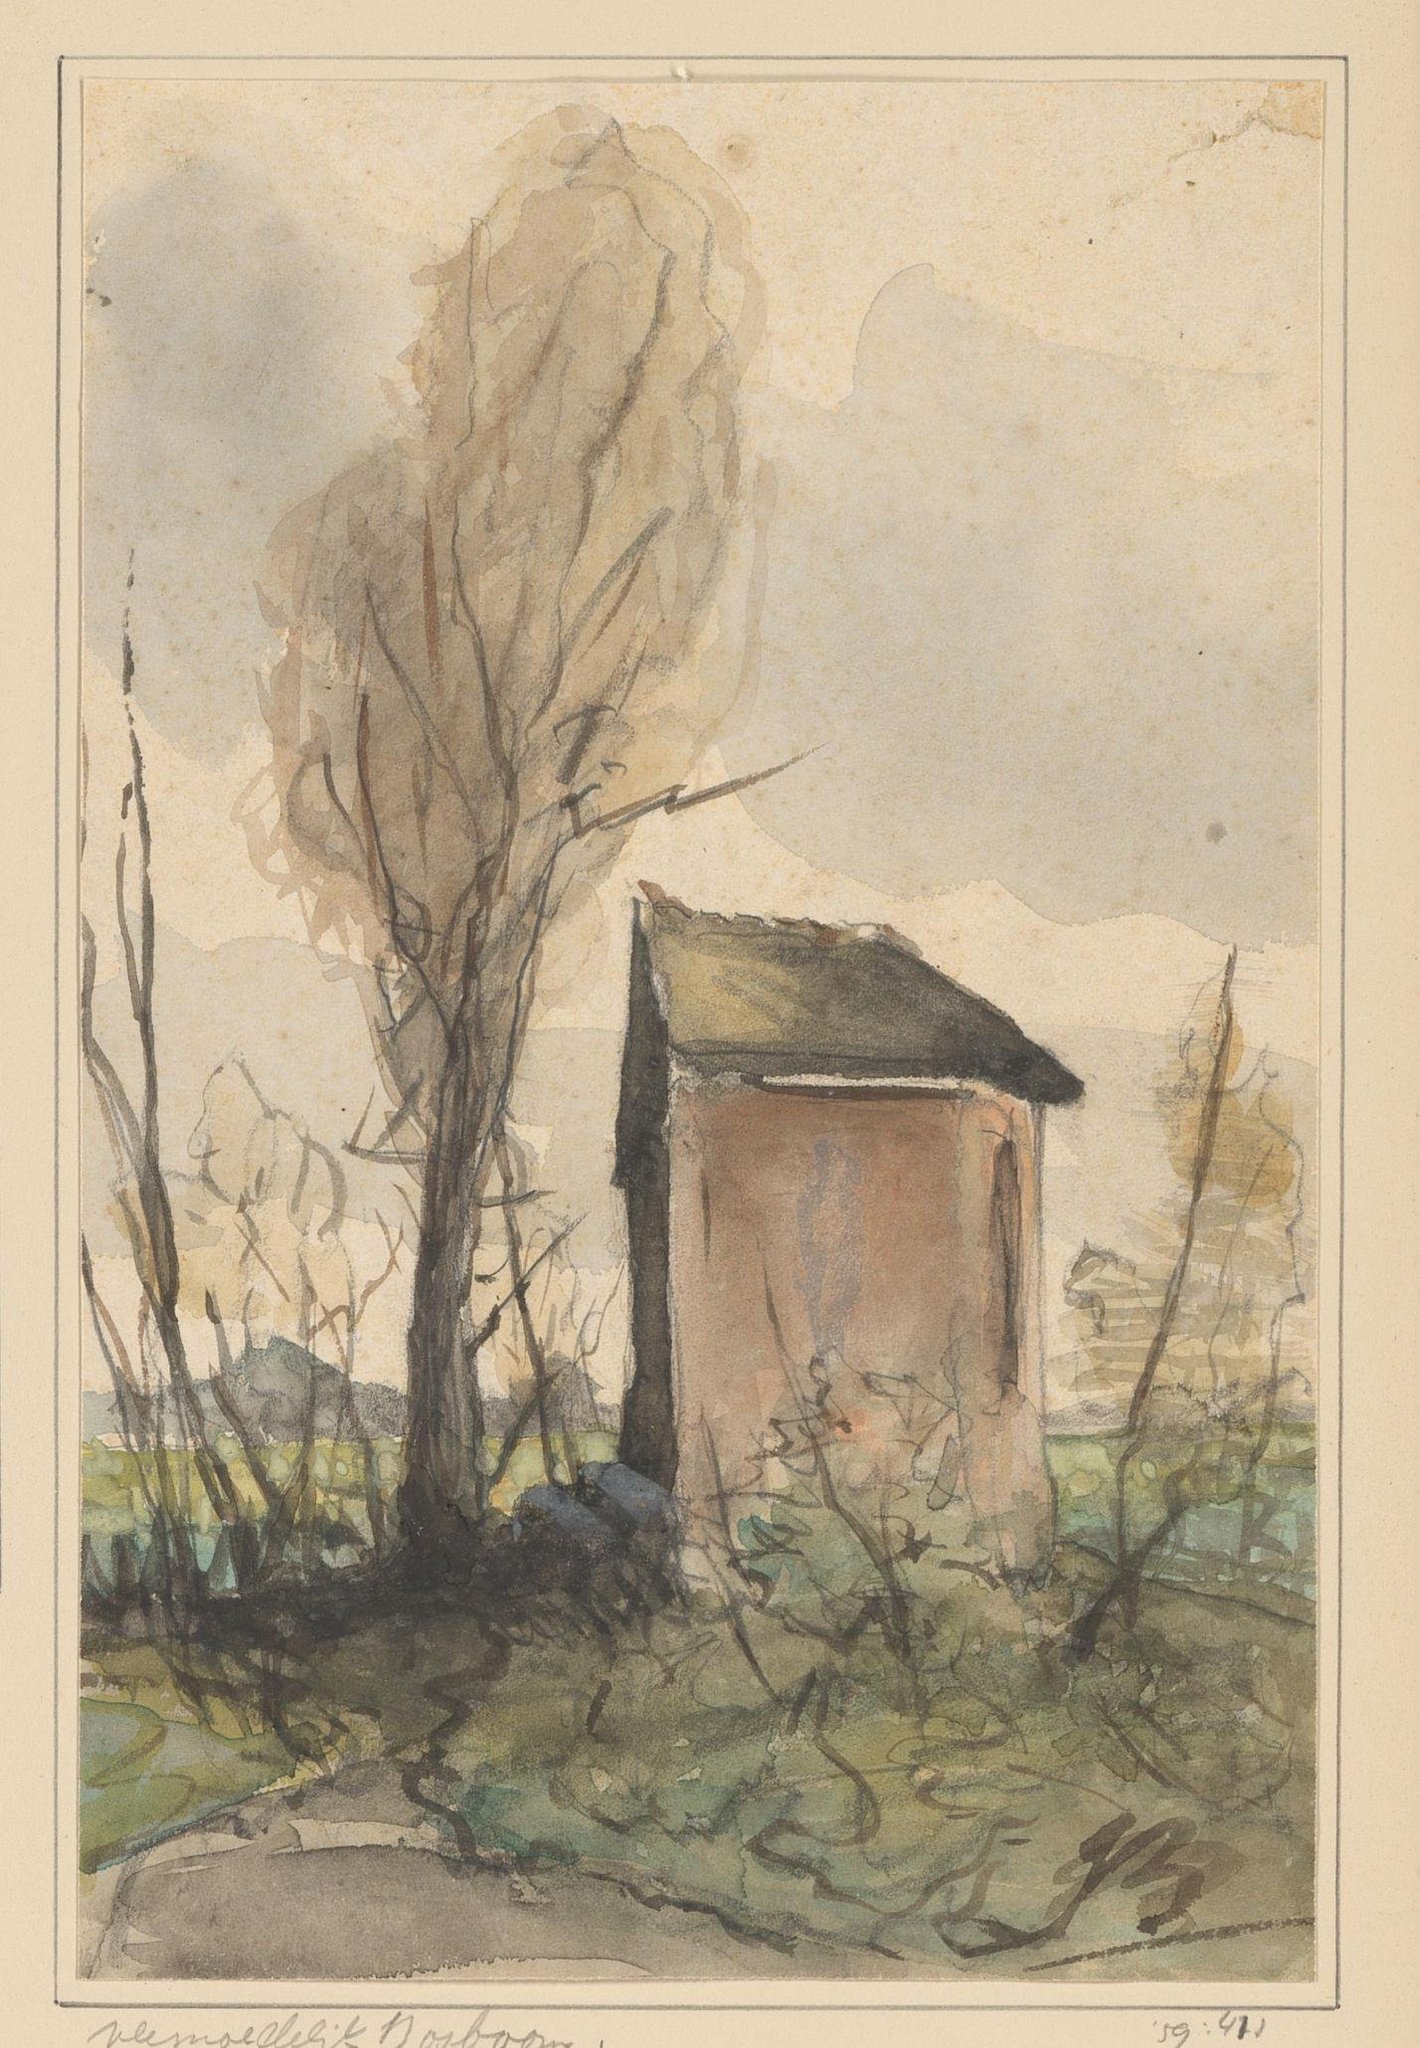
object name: drawing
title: Landschap met kapel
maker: johannes bosboom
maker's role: draughtsman, painter, print maker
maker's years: 1817-1891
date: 1827-1891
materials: paper, watercolor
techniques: brush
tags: city-view, and landscape with man-made constructions, parts of church exterior and annexes - qq - small church, chapel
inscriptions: inscription: ‘vermoedelijk Bosboom.’